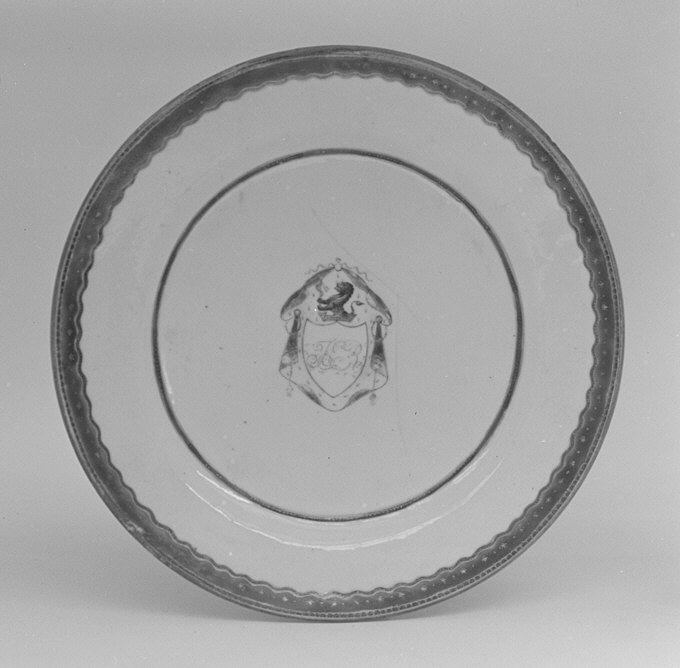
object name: plate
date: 1745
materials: hard paste porcelain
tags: coat of arms